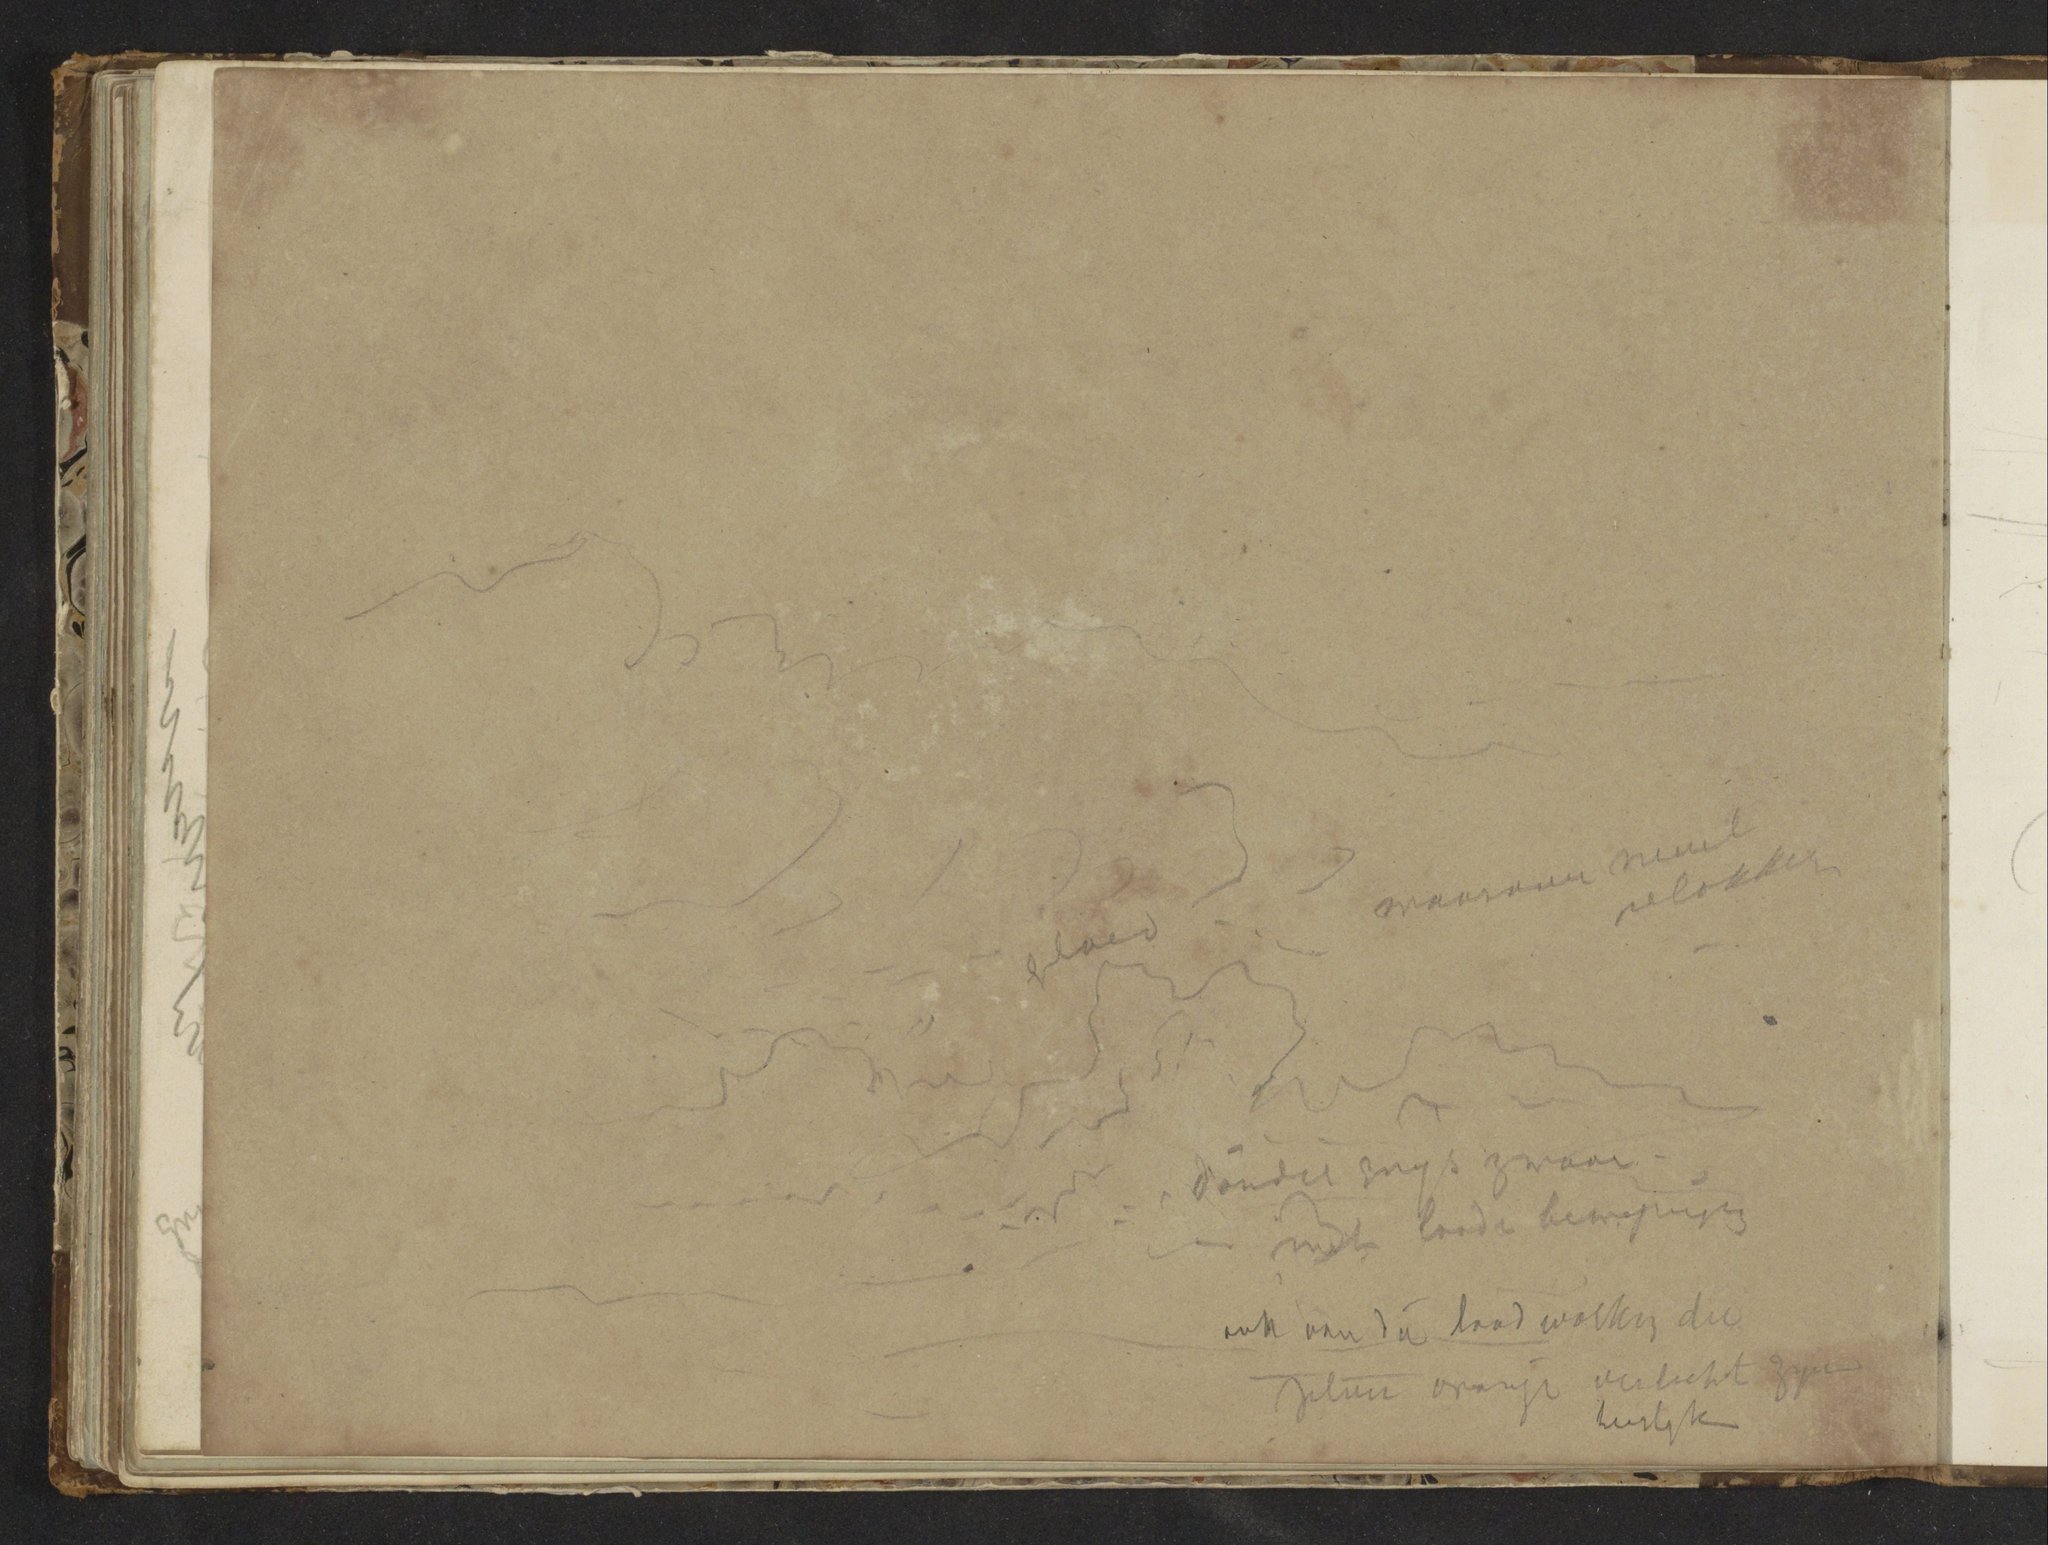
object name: sketchbook leaf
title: Landschap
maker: johannes tavenraat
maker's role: draughtsman, painter, print maker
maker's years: 1809-1881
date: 1833-1841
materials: paper, pencil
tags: trees, landscapes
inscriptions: kleurnotitie, handgeschreven in potlood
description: Blad 40 verso uit een schetsboek met 41 bladen.